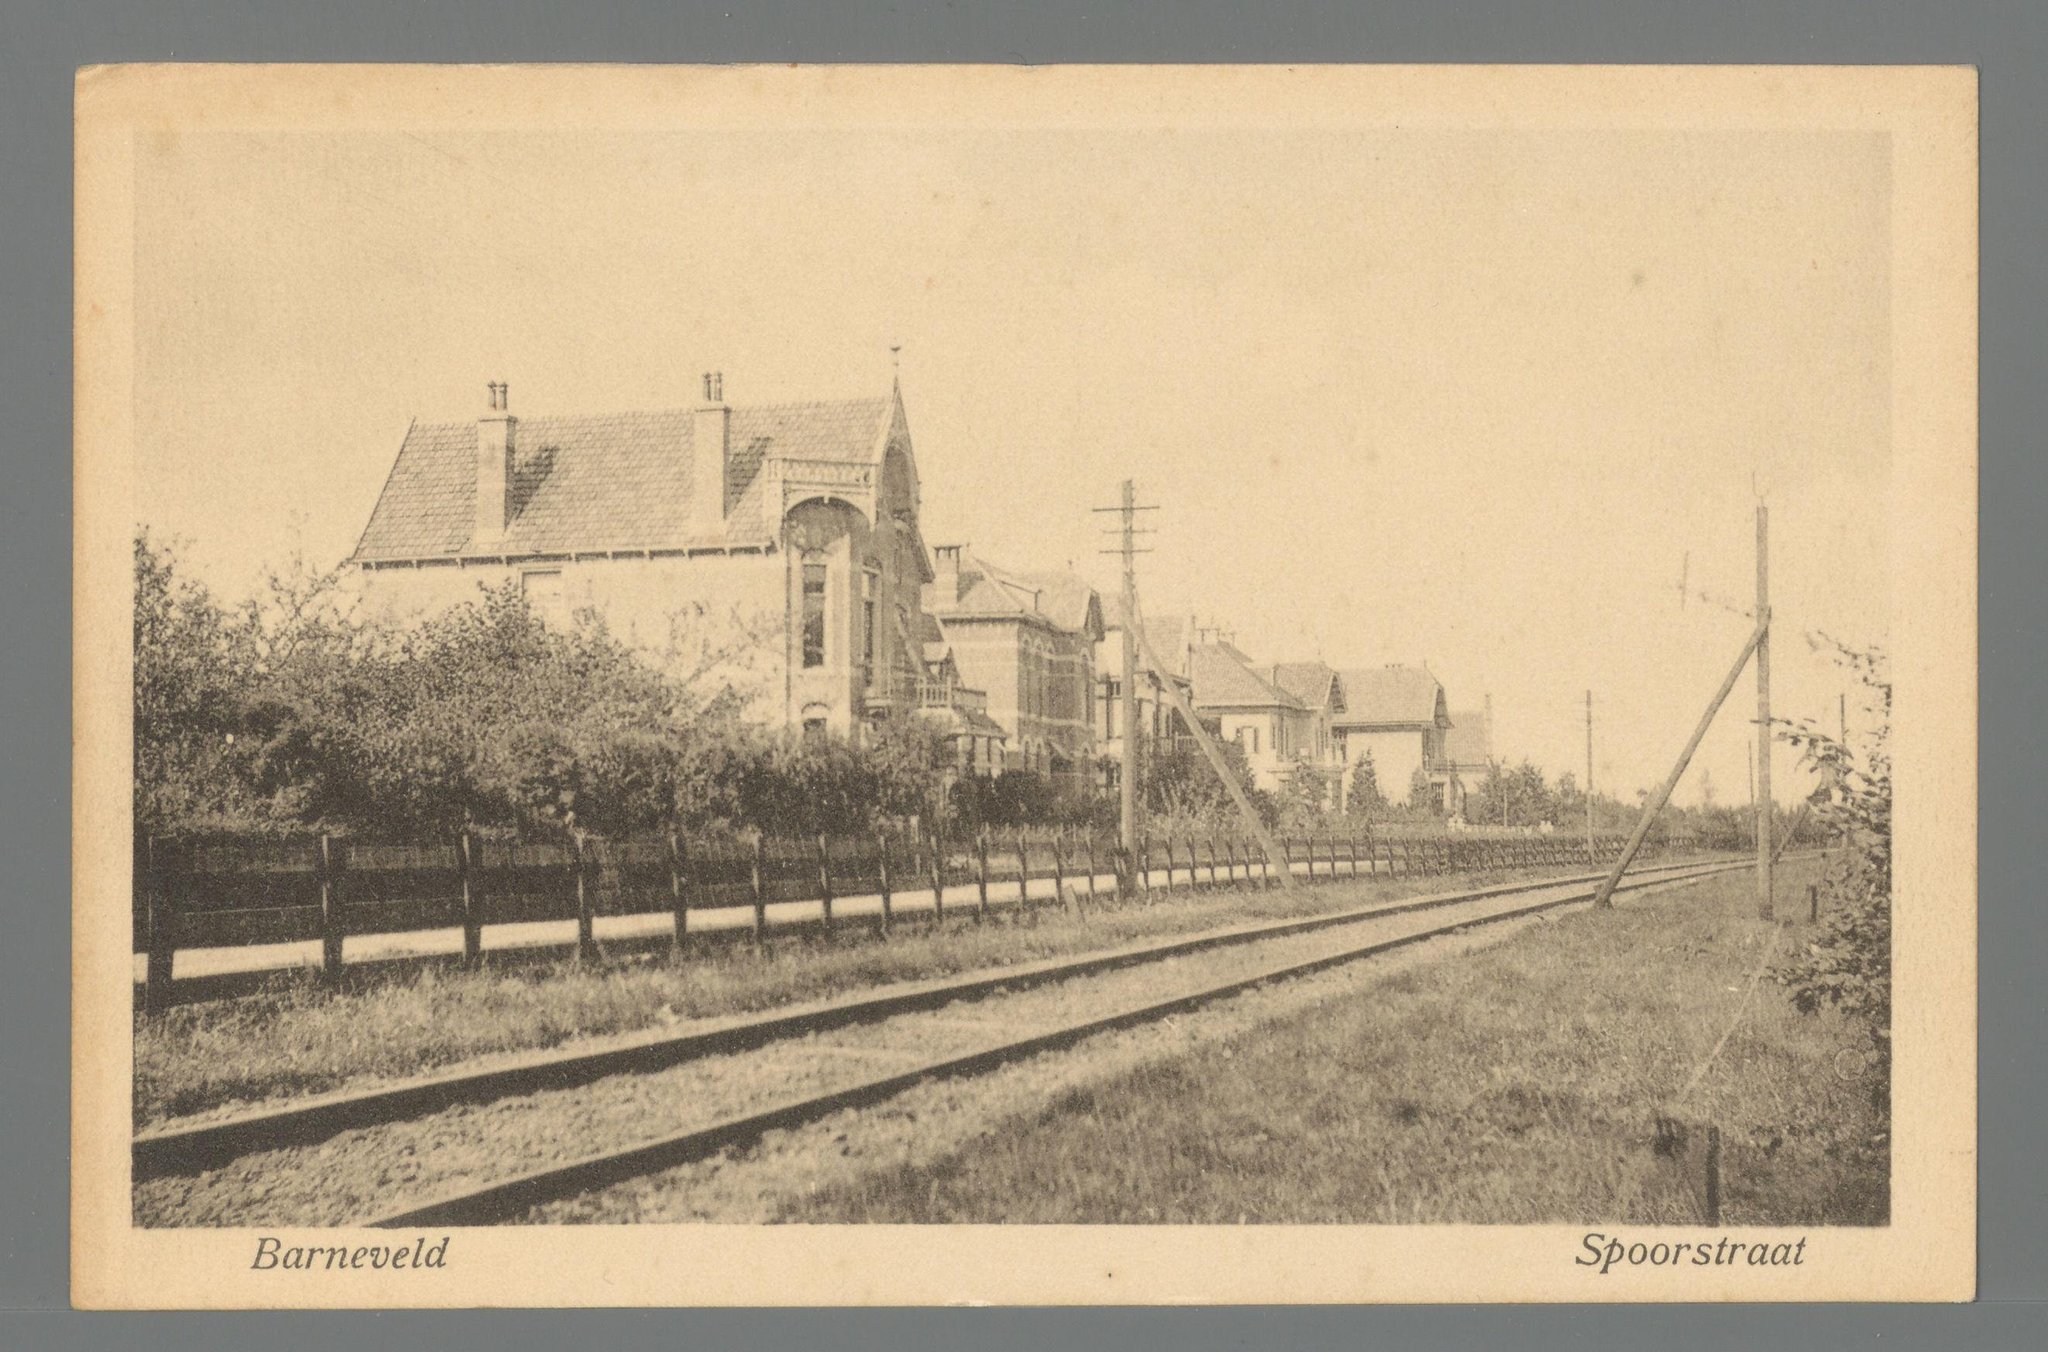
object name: photomechanical print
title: Barneveld. Spoorstraat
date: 1913-1930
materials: cardboard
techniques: photograph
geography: barneveld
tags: railway, train, street